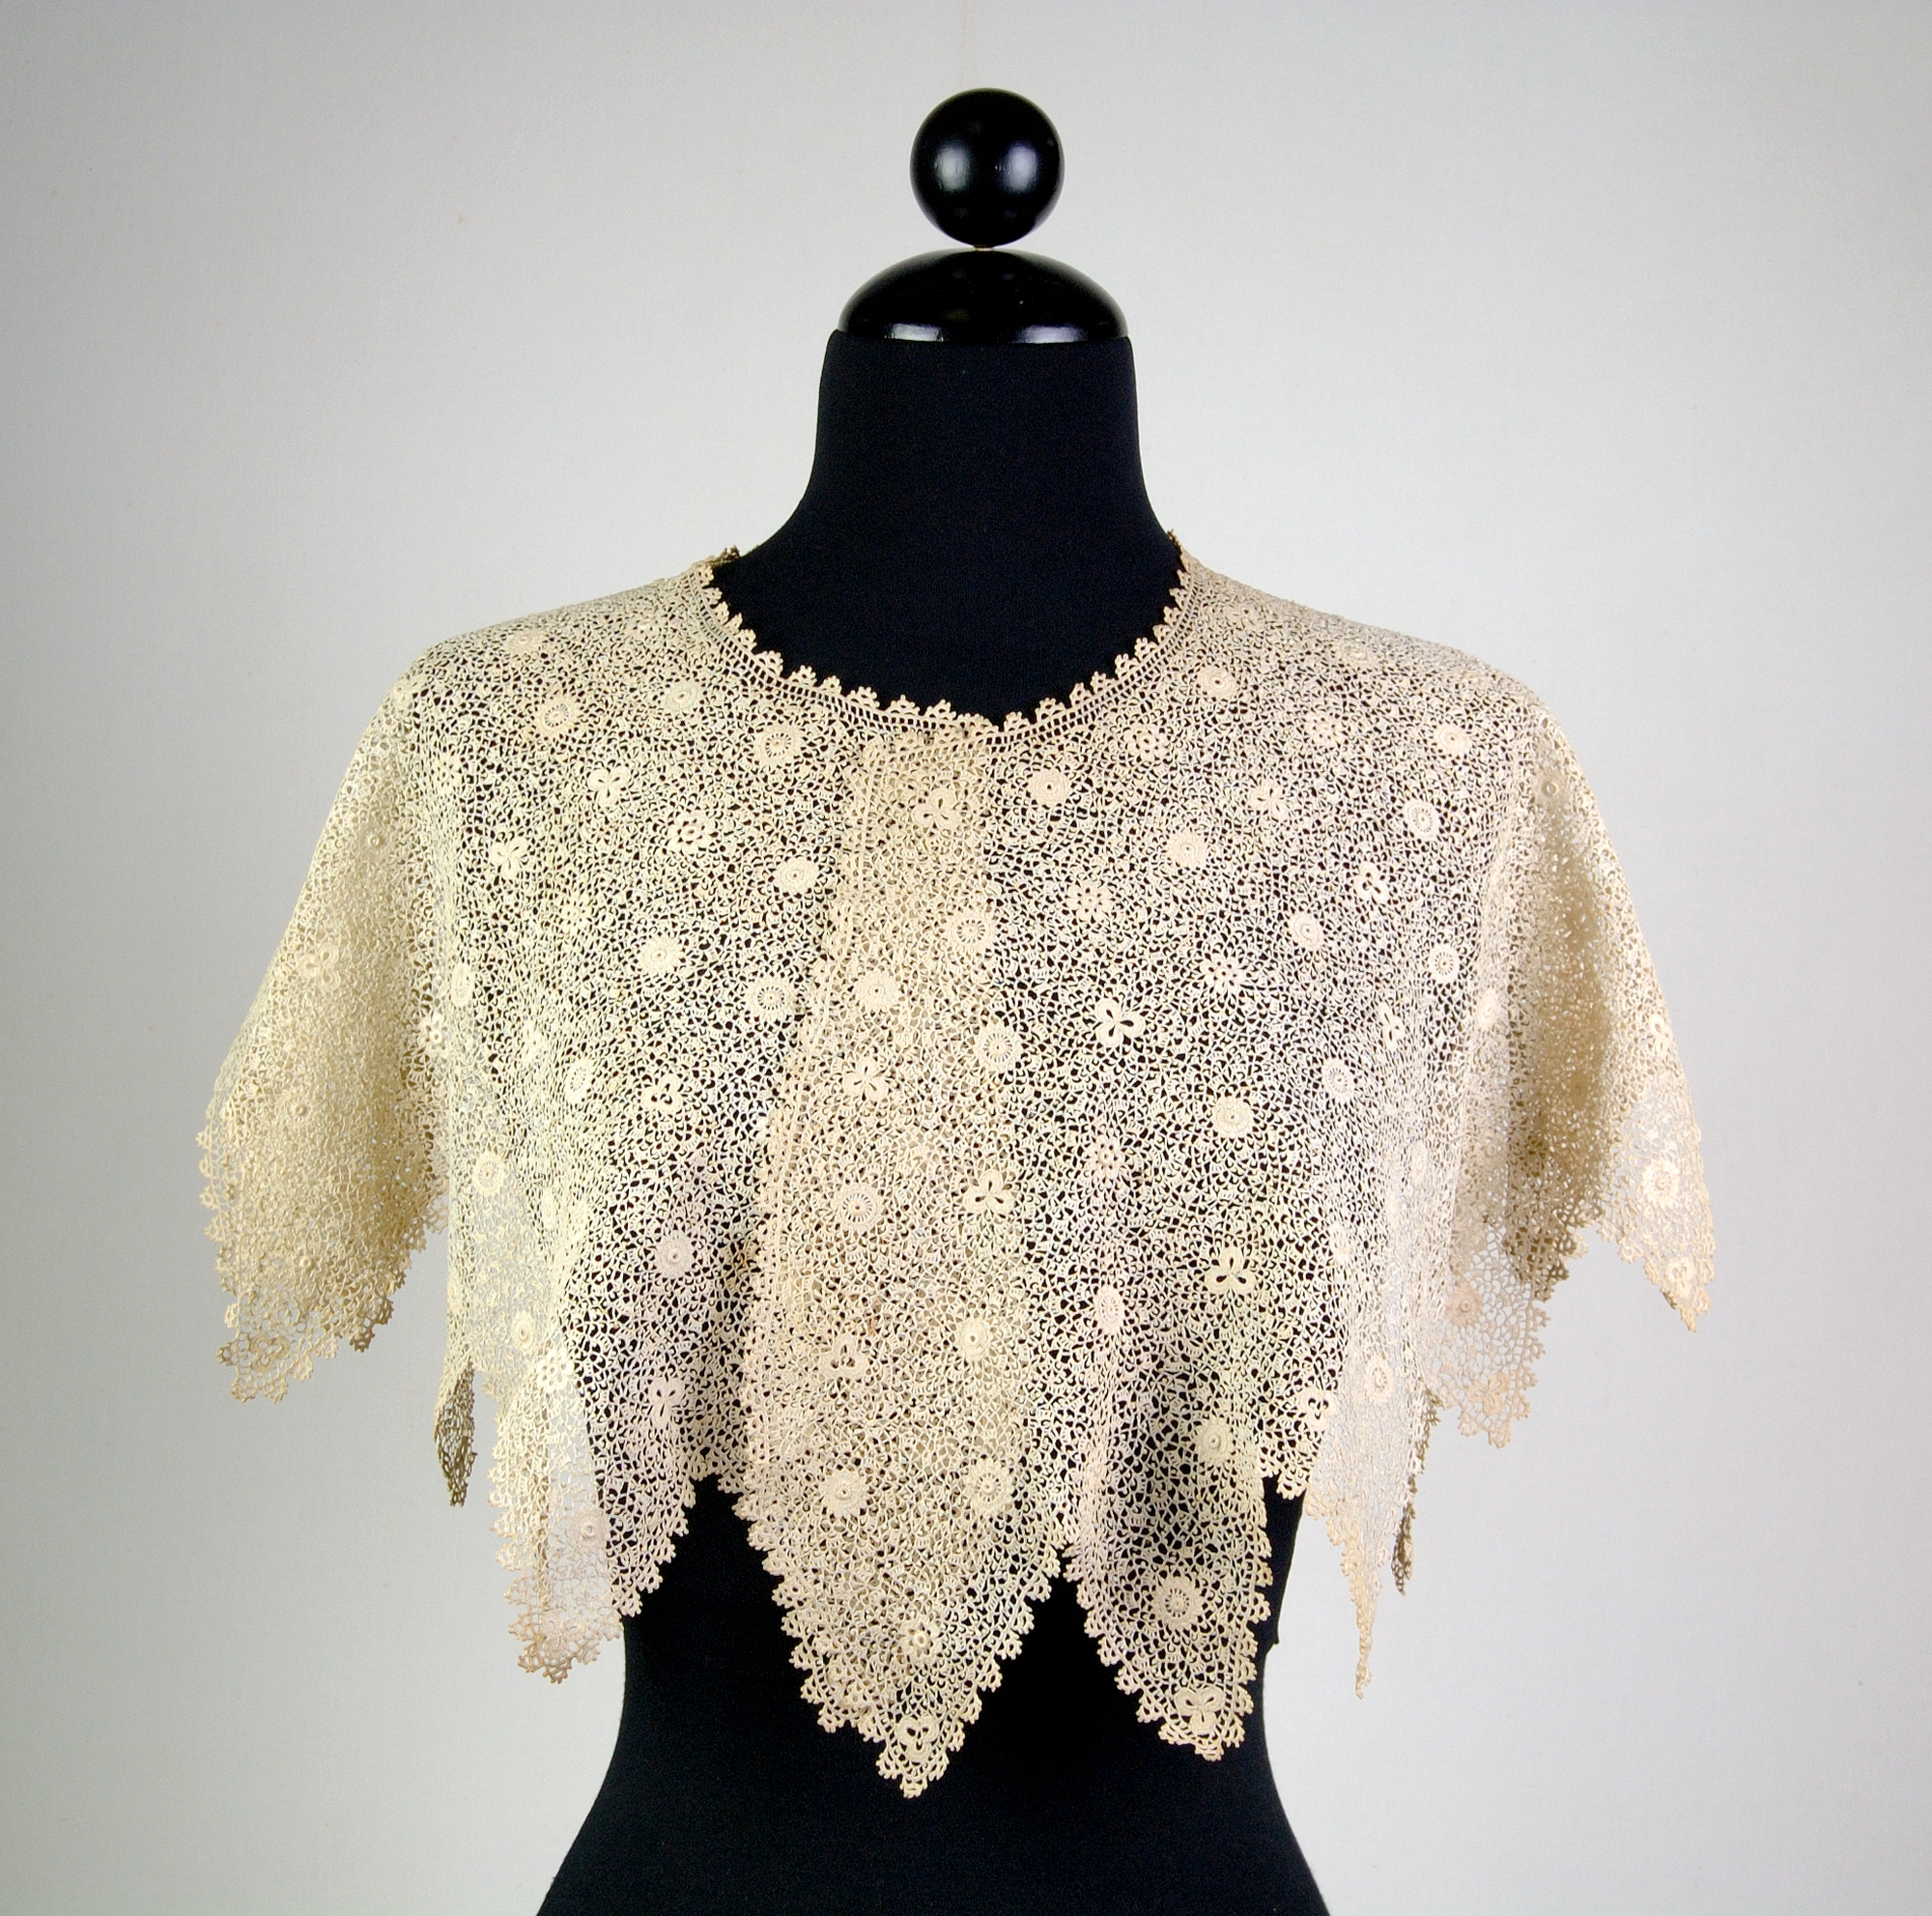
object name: collar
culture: irish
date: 1895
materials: cotton